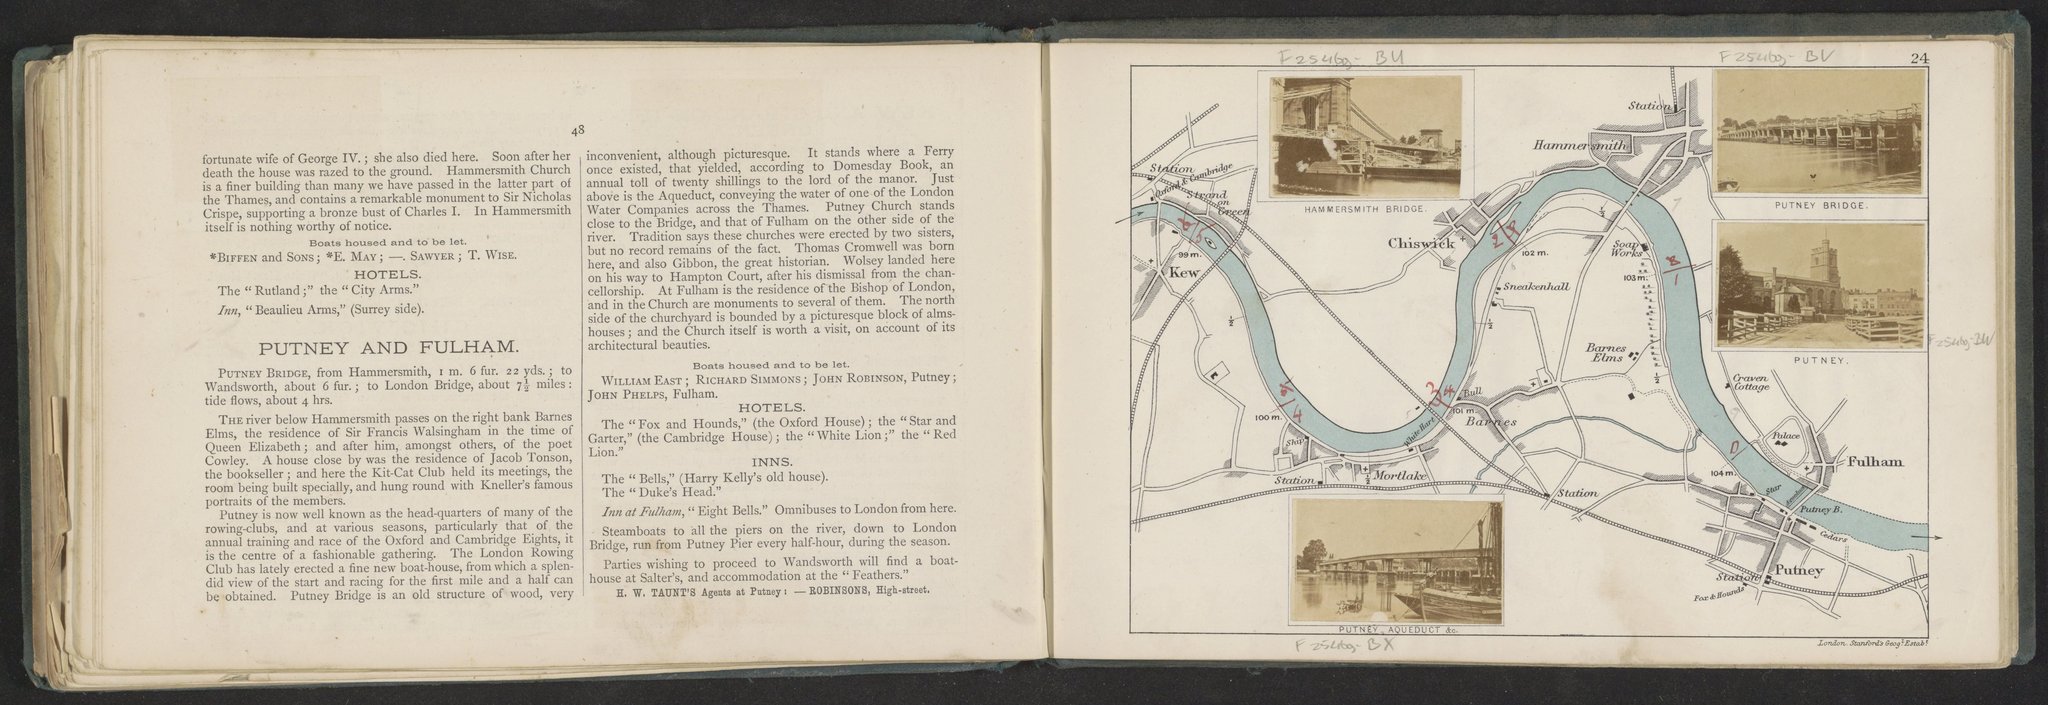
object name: page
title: Putney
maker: henry w. taunt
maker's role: fotograaf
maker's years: 1842-1922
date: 1871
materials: photographic support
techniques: albumen print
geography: putney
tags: putney